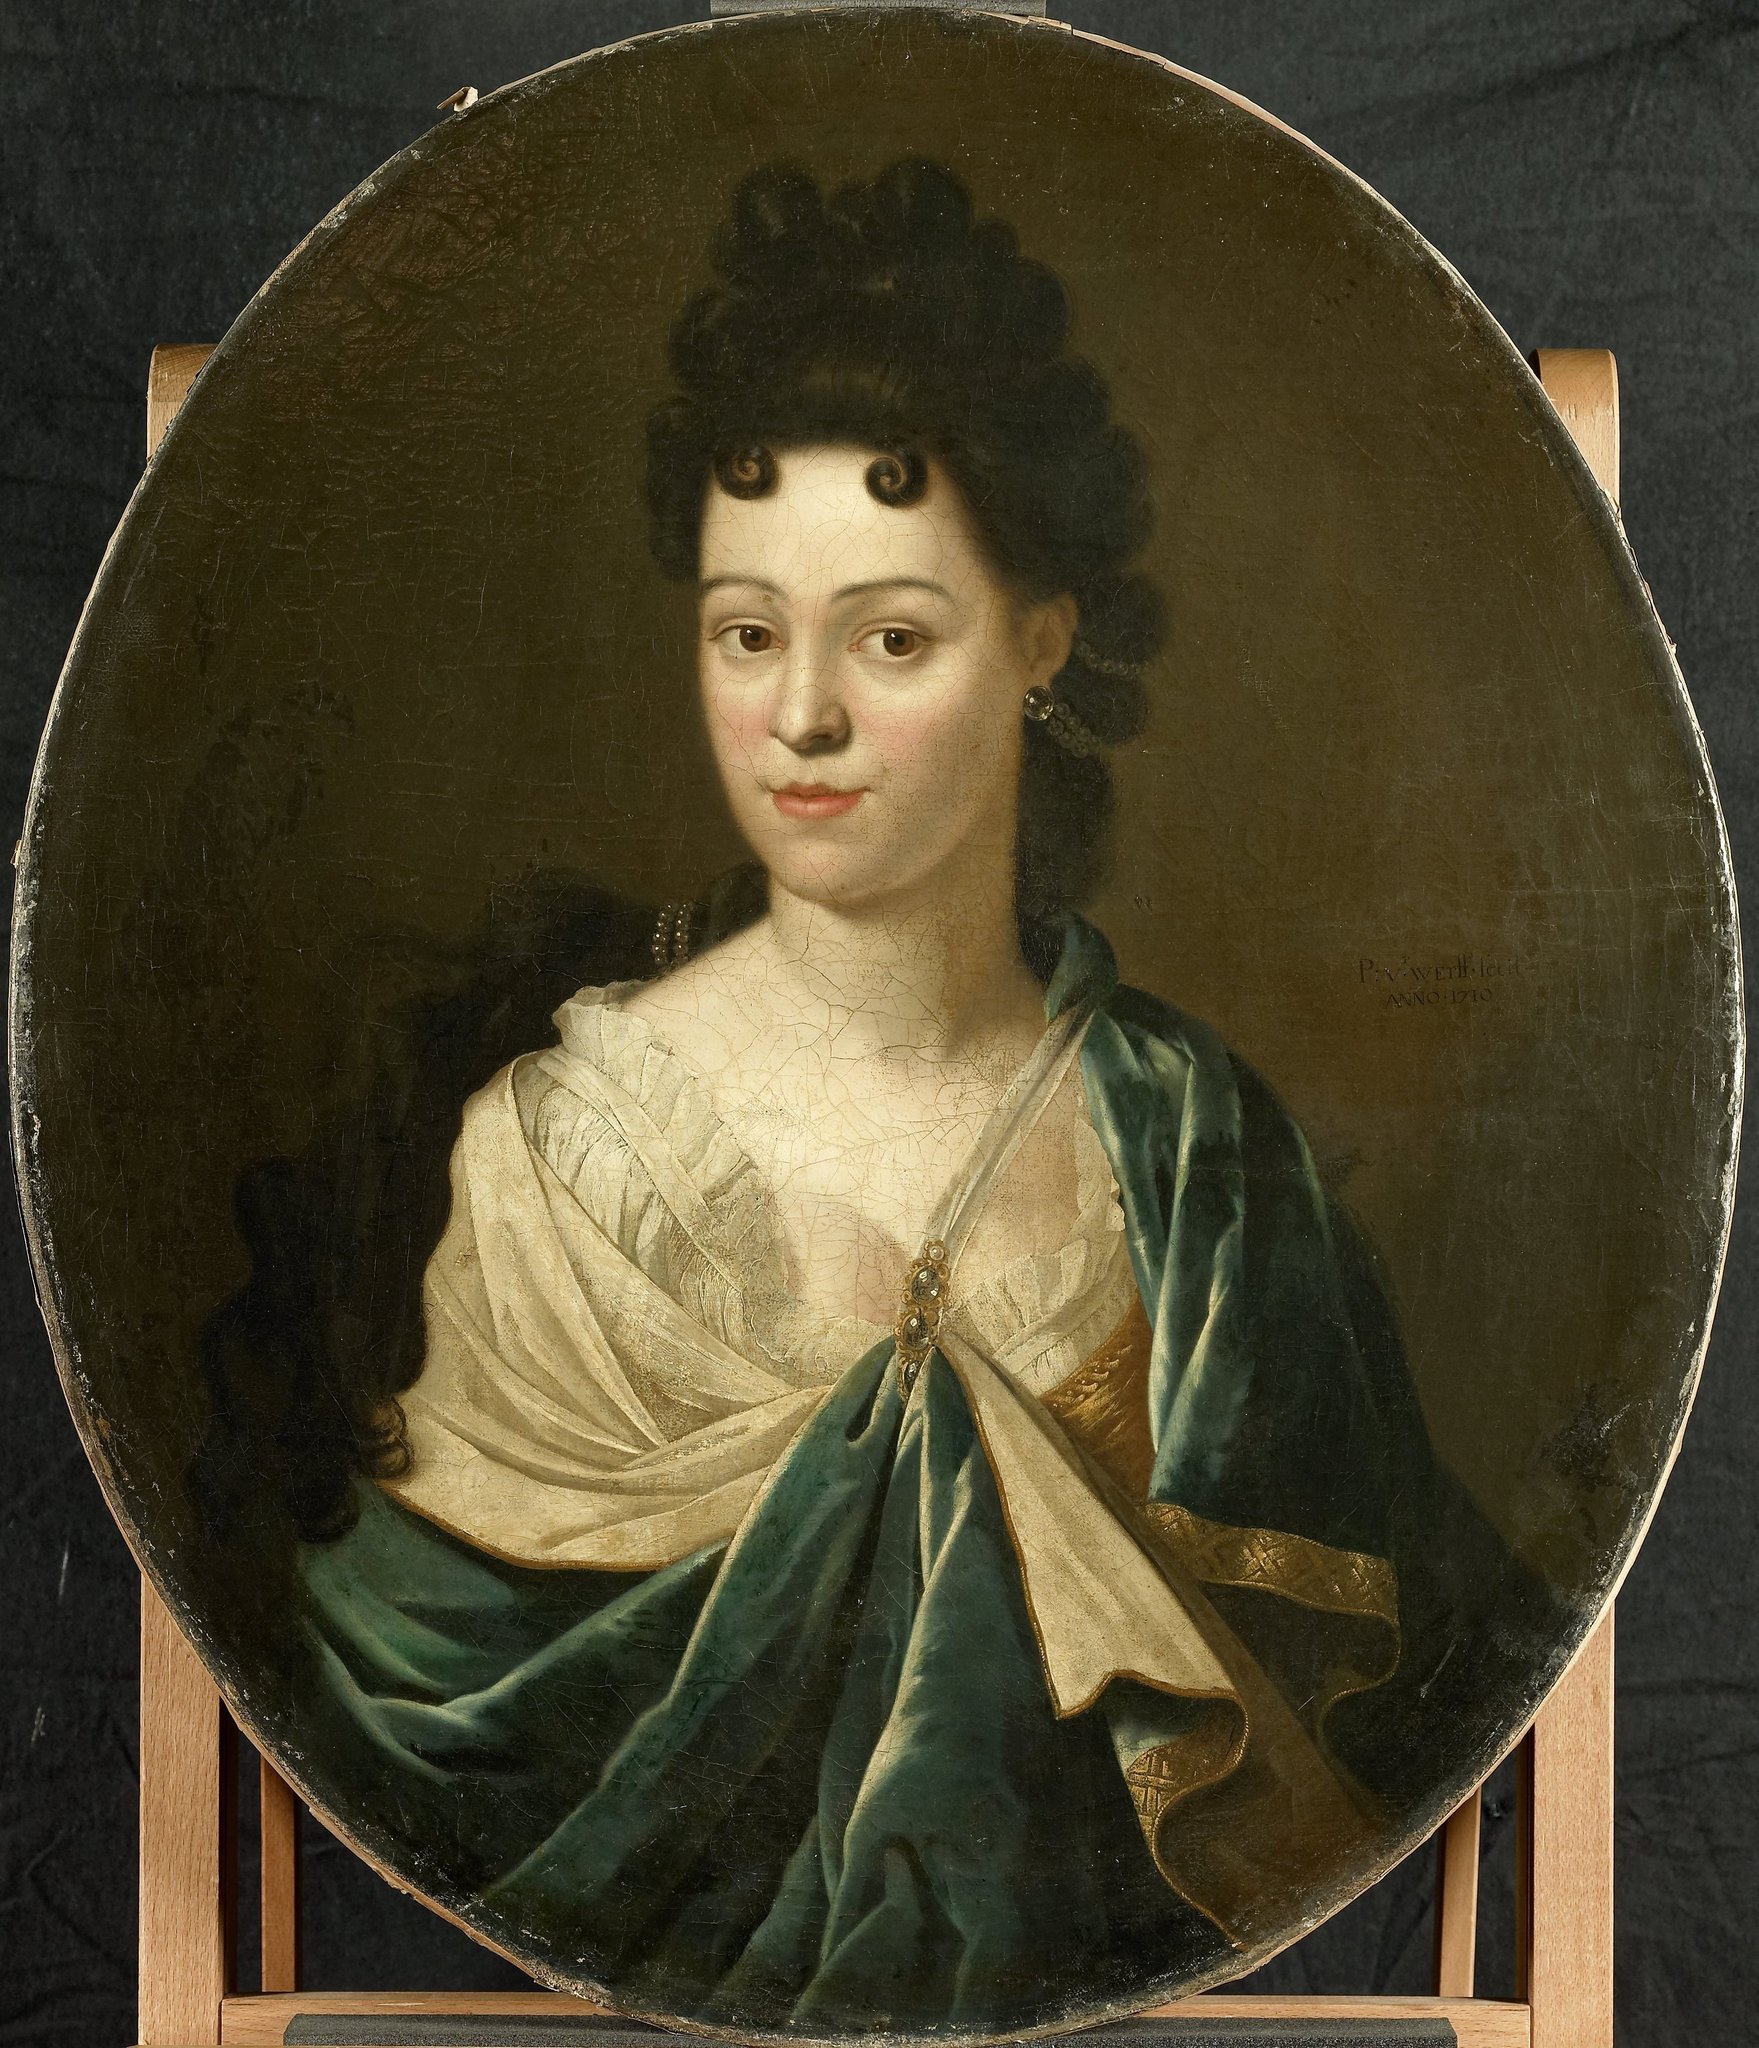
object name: painting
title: Portrait of Mrs. Brust-Batailhy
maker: pieter van der werff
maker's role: draughtsman, painter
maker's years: 1665-1722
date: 1710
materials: canvas, oil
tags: historical persons - bb - woman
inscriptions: signature and date: ‘P: v.r Werff. fecit Anno. 1710’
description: De familienaam Batailheij heeft verschillende spellingsvarianten: Batailhij, Bataelheij, Batailhy en Batailliij. Er is gekozen voor de variant die het meest voorkomt in het Stadsarchief Rotterdam.